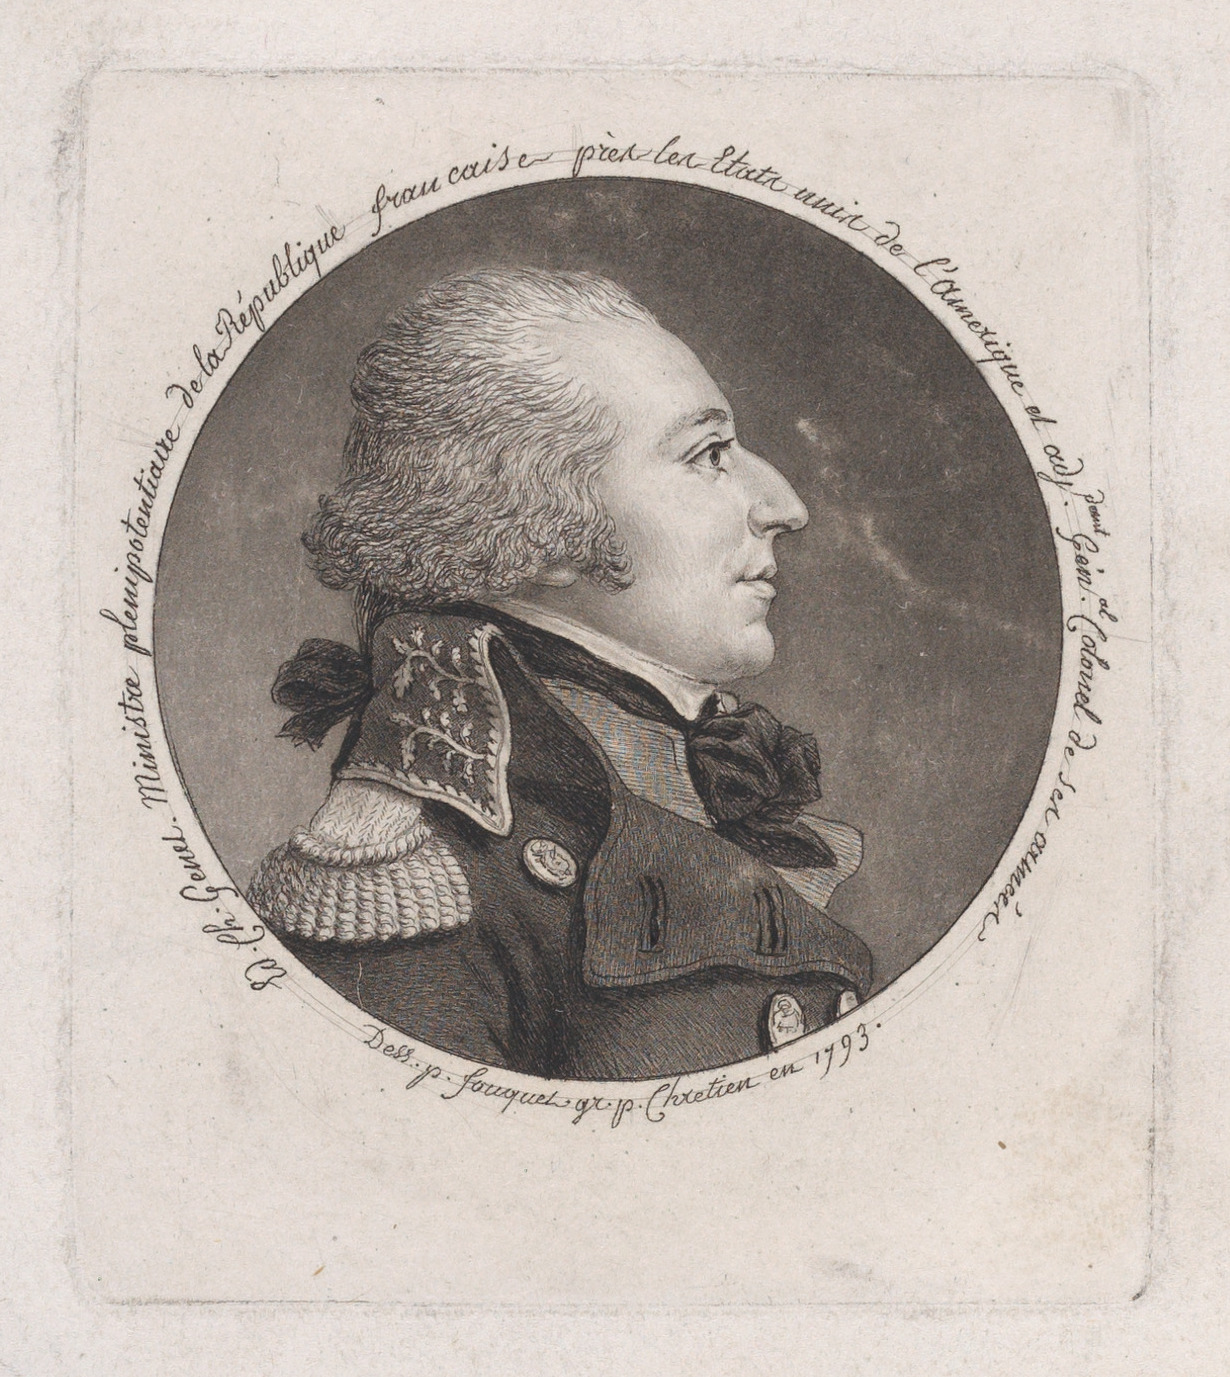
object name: print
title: Portrait of E.C. Genet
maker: gilles louis chrétien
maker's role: artist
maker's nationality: french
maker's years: 1754-1811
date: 1793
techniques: aquatint, etching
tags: men,portraits,profiles